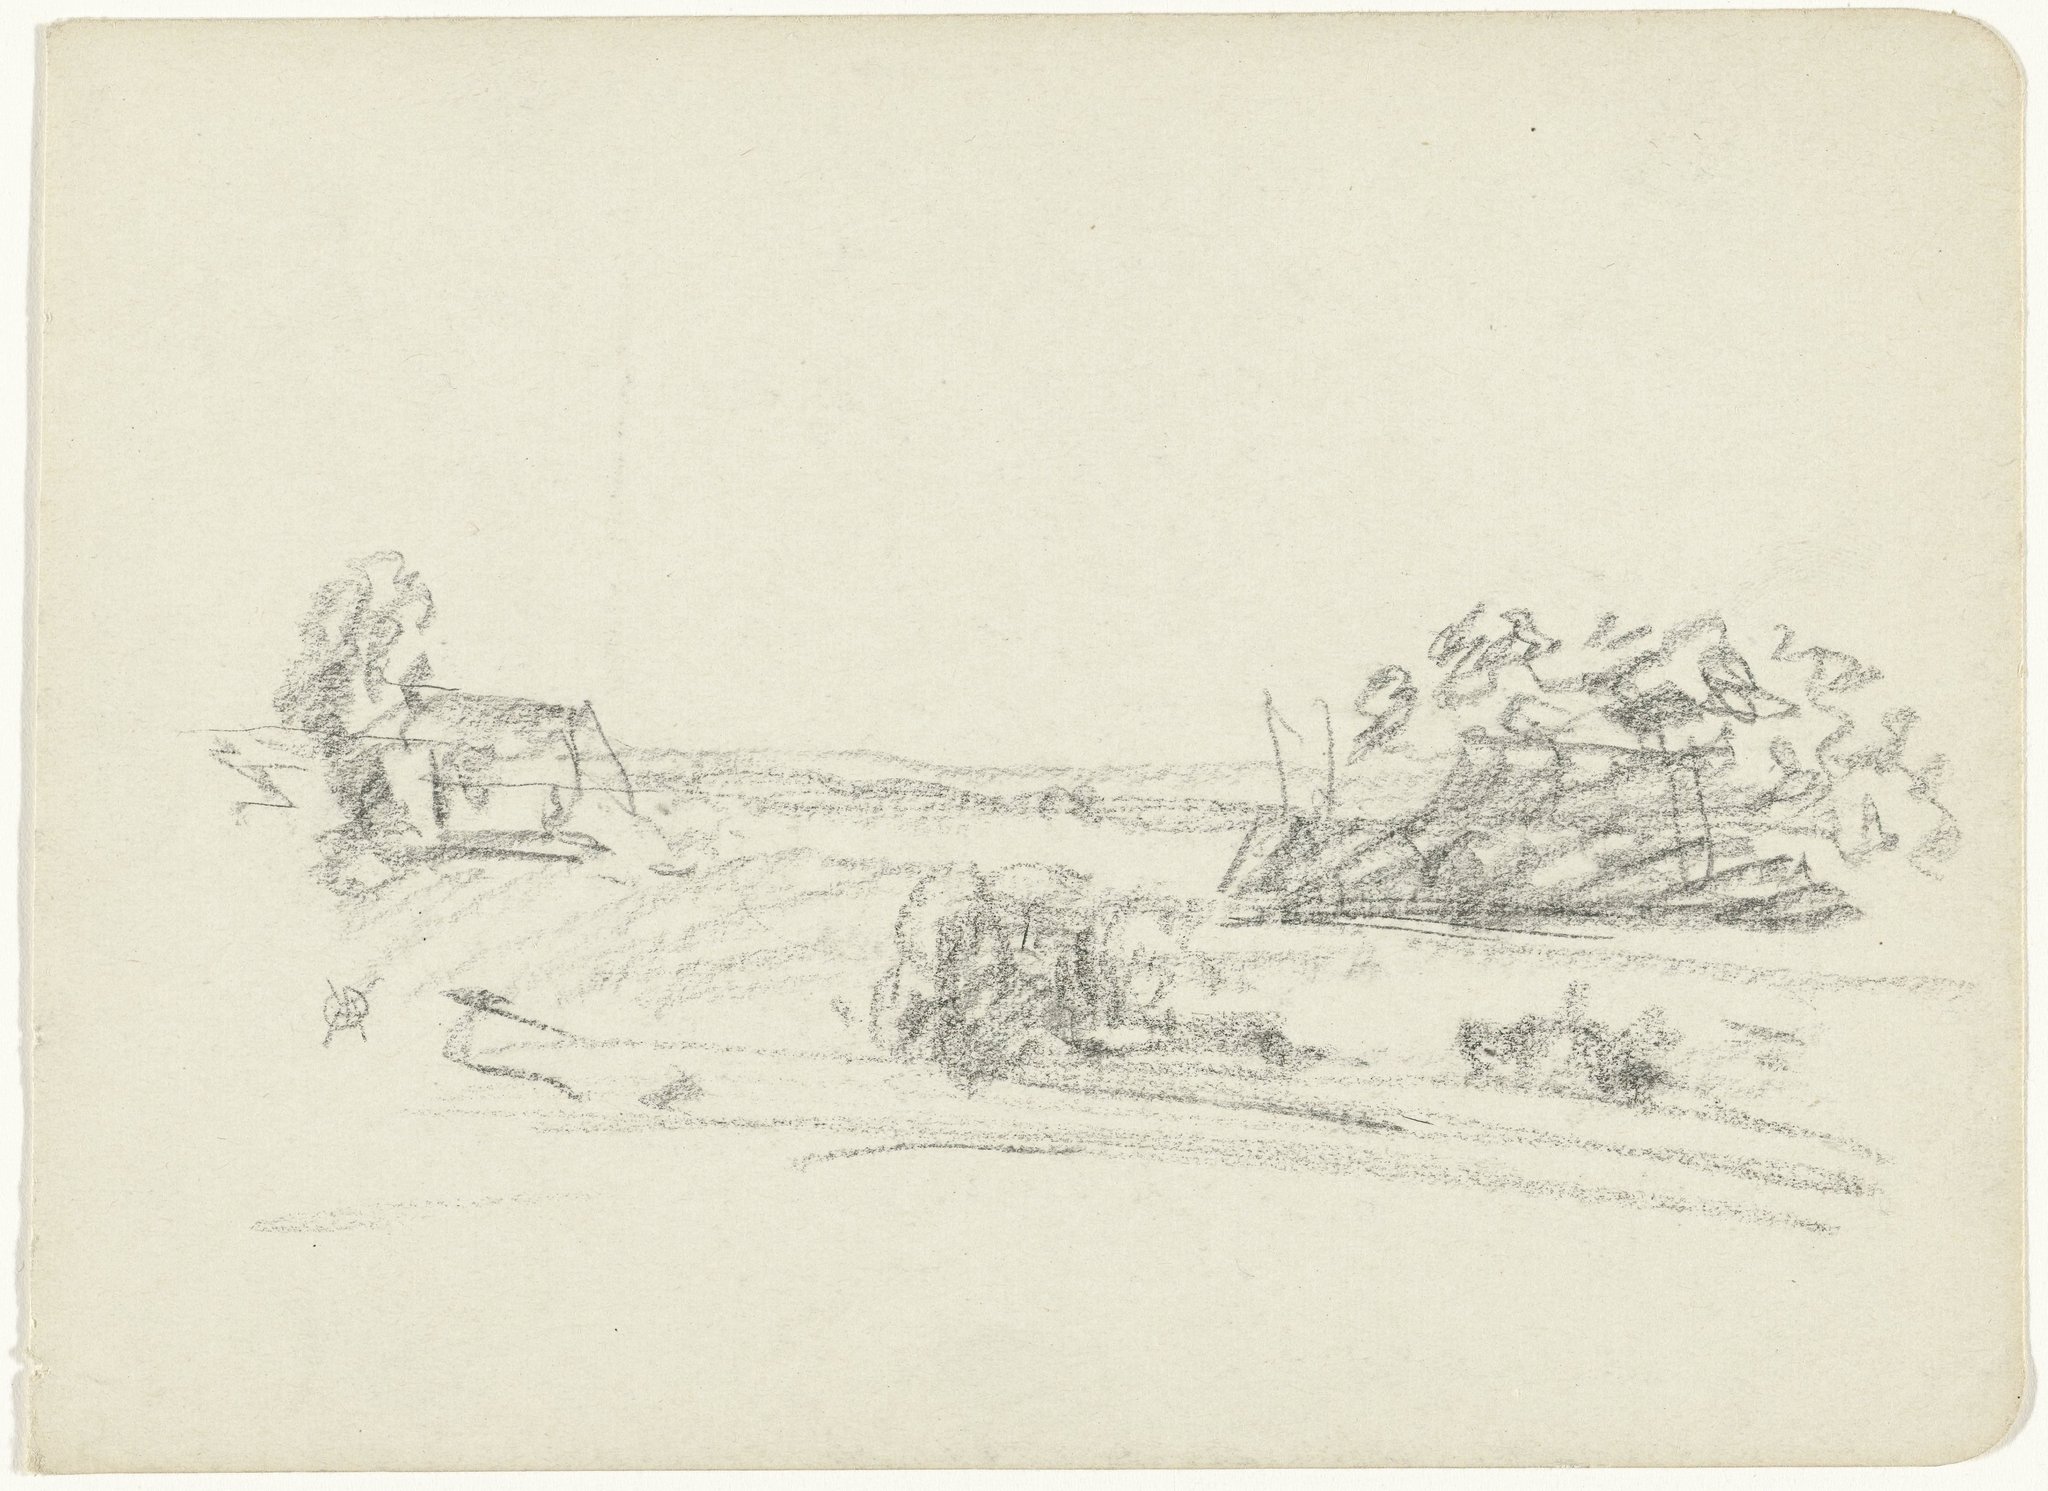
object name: drawing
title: Twee boerderijen tussen geboomte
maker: gerrit willem dijsselhof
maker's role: designer, draughtsman, print maker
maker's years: 1866-1924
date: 1876-1924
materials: chalk, paper